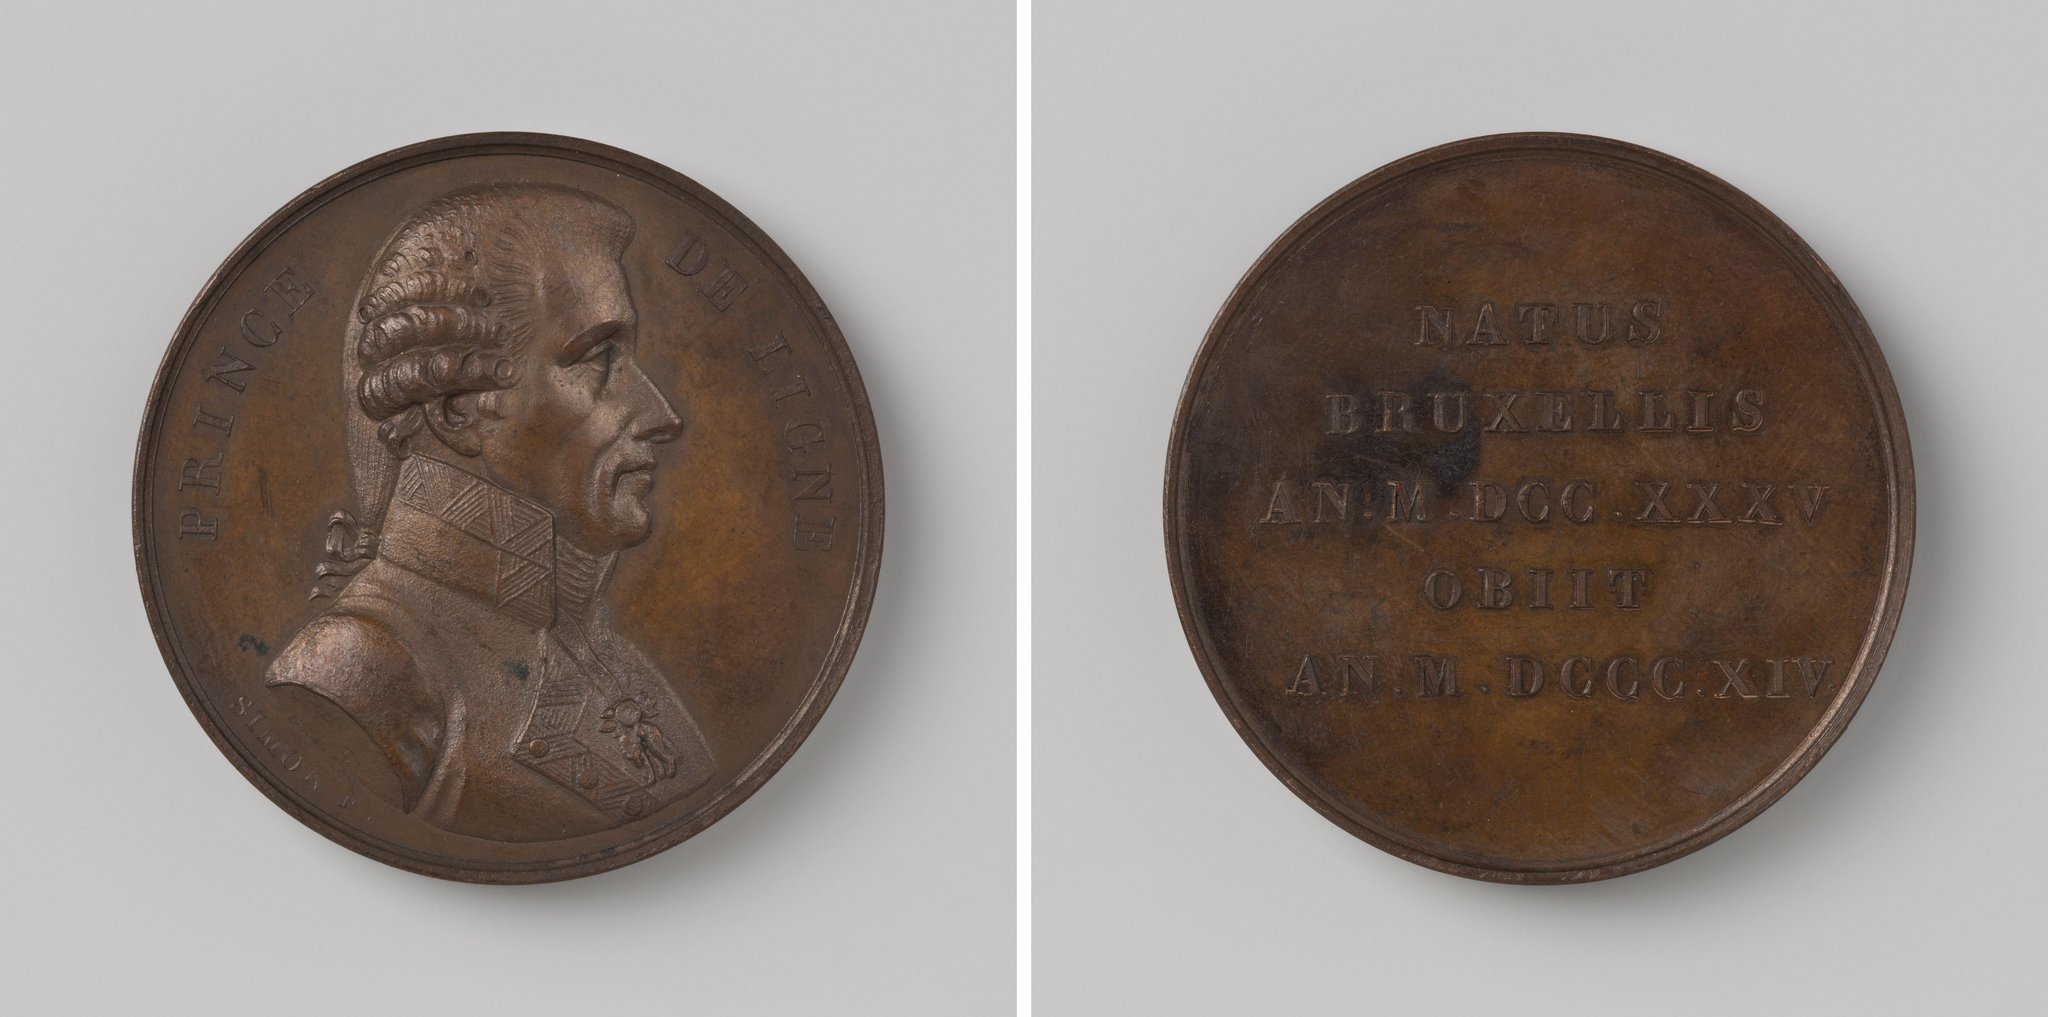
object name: history medal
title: Charles Joseph, prins de Ligne, generaal in Oostenrijkse dienst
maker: jean henri simon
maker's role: medailleur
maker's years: 1752-1834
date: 1816-1834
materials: bronze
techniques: striking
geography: brussels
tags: vienna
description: Bronzen penning. Voorzijde: borststuk man binnen omschrift. Keerzijde: opschrift